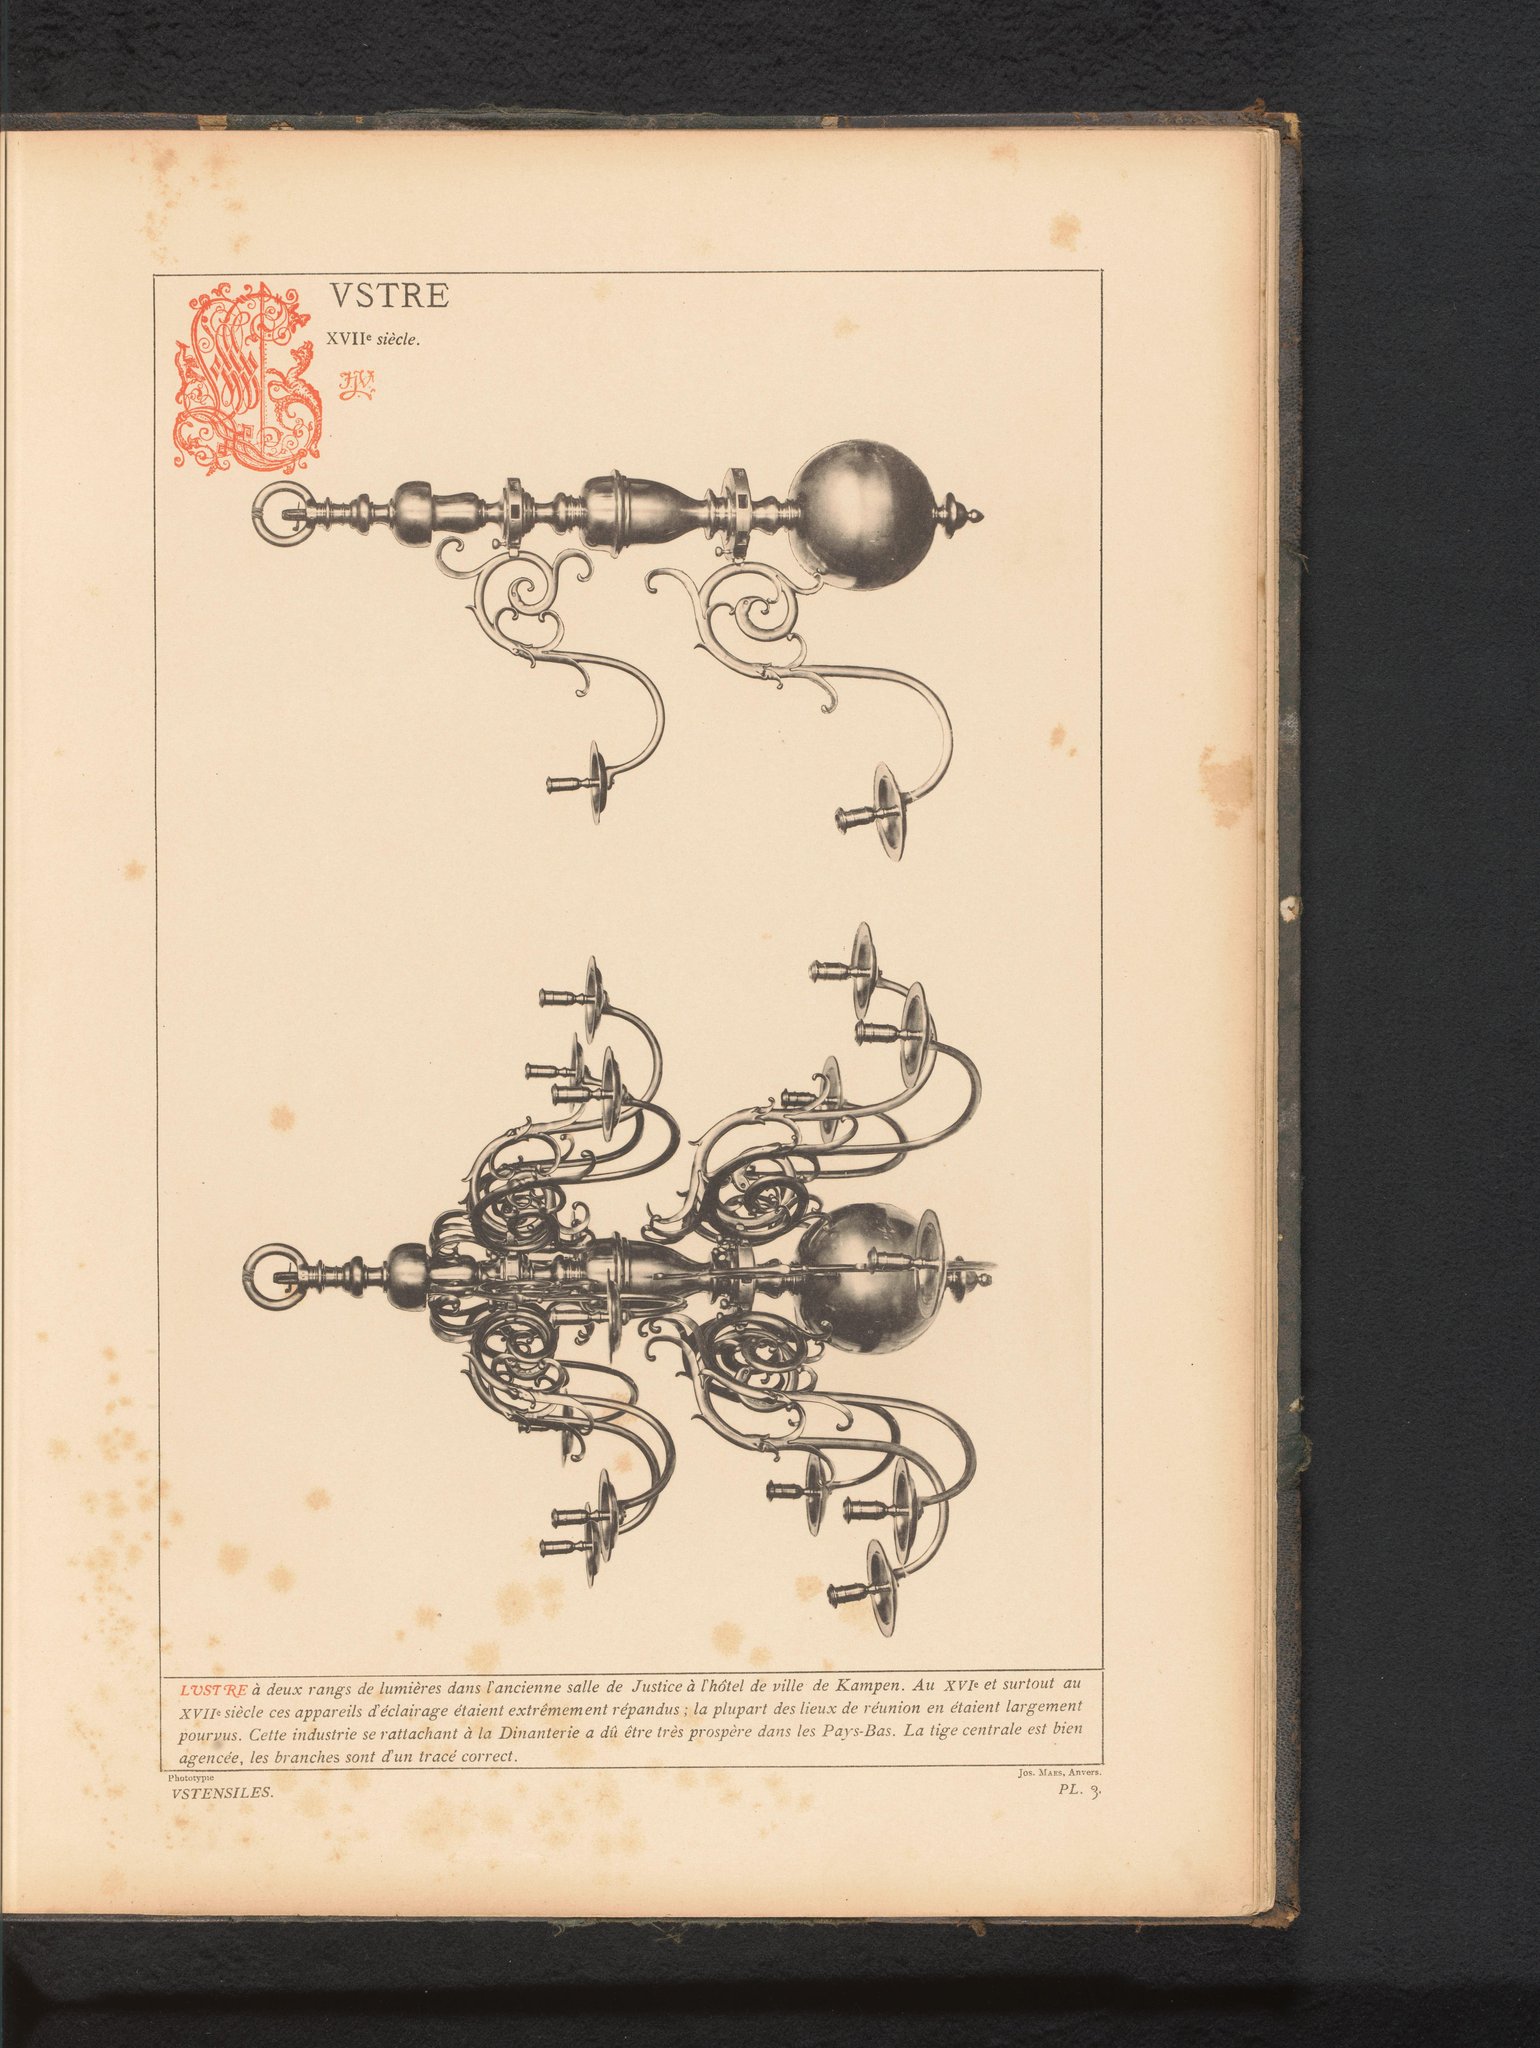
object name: photomechanical print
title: Lustre, XVIIe siècle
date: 1882-1887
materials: paper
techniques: photograph, photolithography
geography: antwerp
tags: chandelier, candelabrum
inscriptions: inscription: ‘LUSTRE à deux (...)’, inscription: ‘UTENSILES. - PL. 3.’, monogram: ‘JJvY’